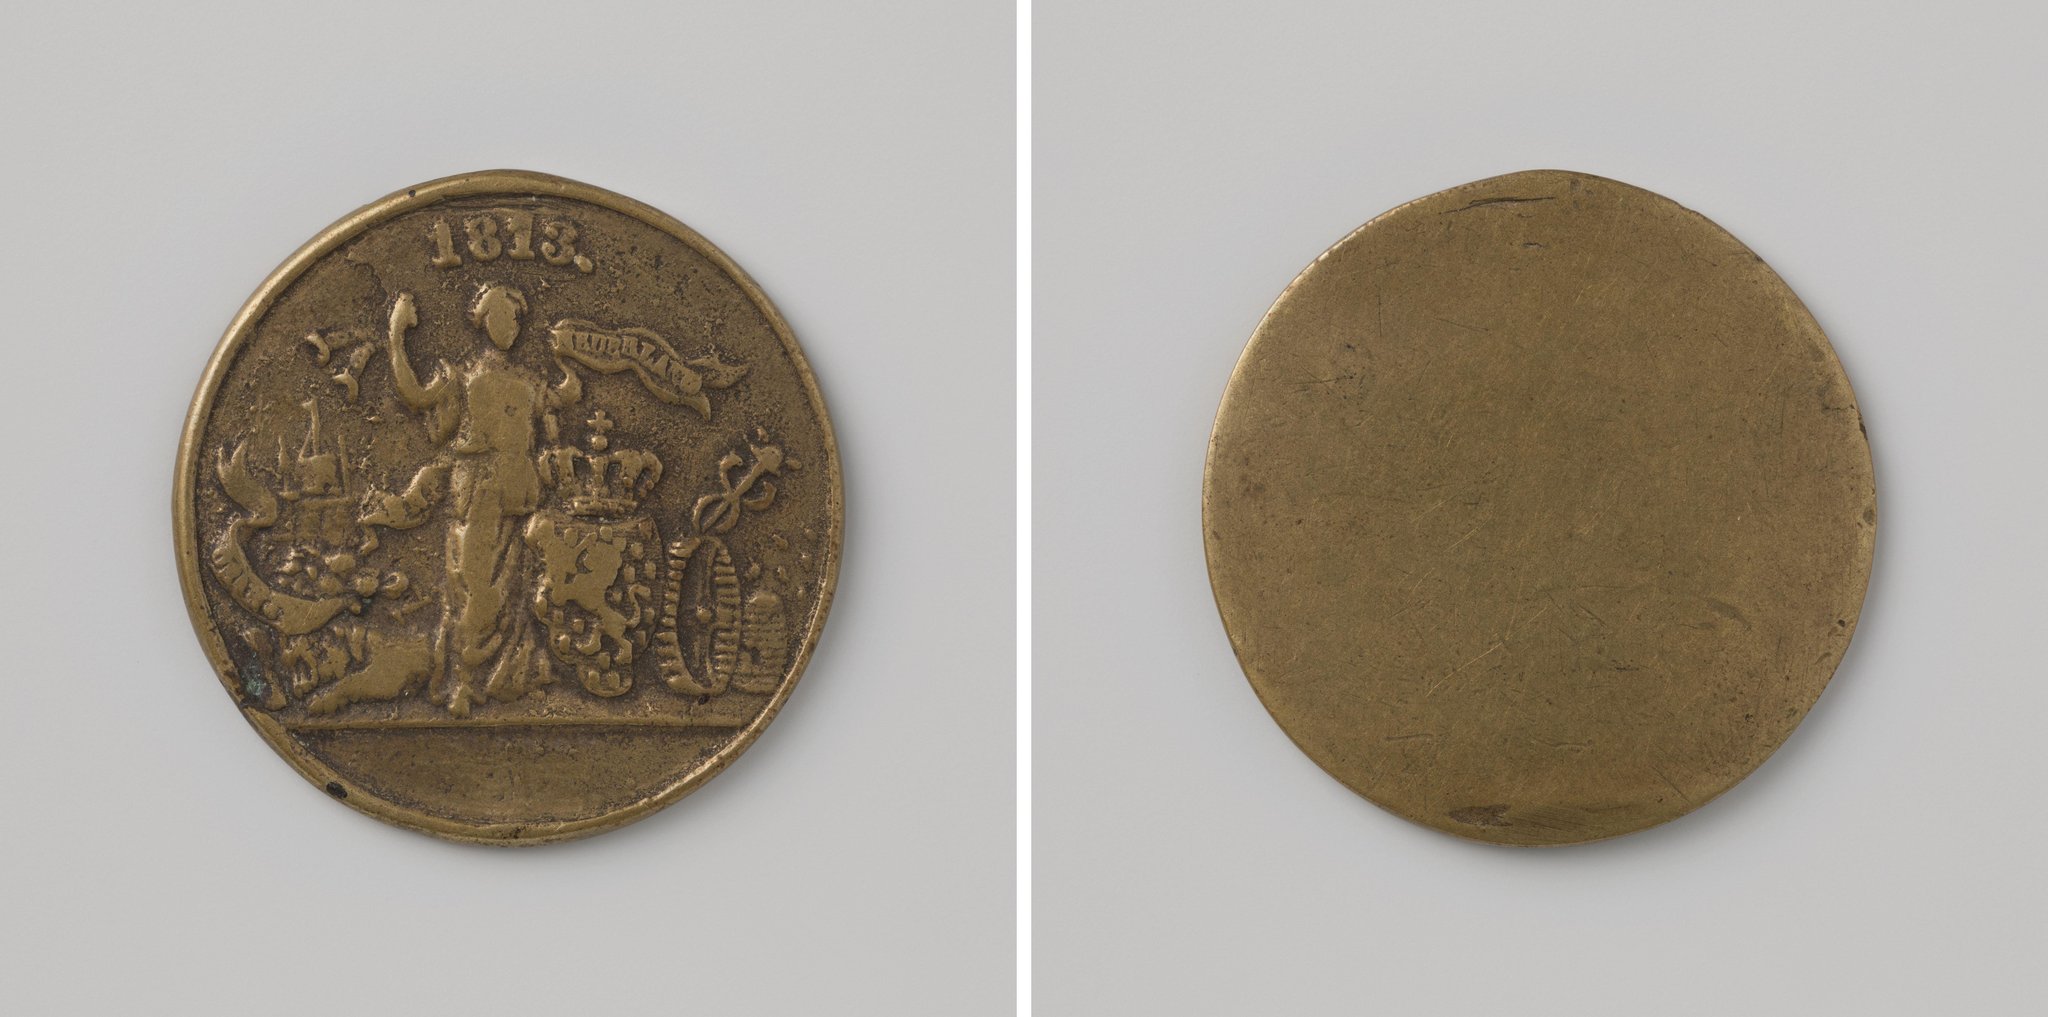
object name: history medal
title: Vijftigjarige viering van de onafhankelijkheid van Nederland te Rotterdam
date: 1863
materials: copper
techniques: striking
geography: the hague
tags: netherlands, rotterdam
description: Eenzijdige koperen penning. Voorzijde: Nederlandse maagd met in rechterhand verbroken ketens en in linkerhand gekroond wapenschild staat tussen liggende leeuw met pijlenbundel en wimpel met opschrift in bek, en mercuriusstaf, rad, bijenkorf en bijen; op achtergrond schip op zee. Keerzijde: blanco